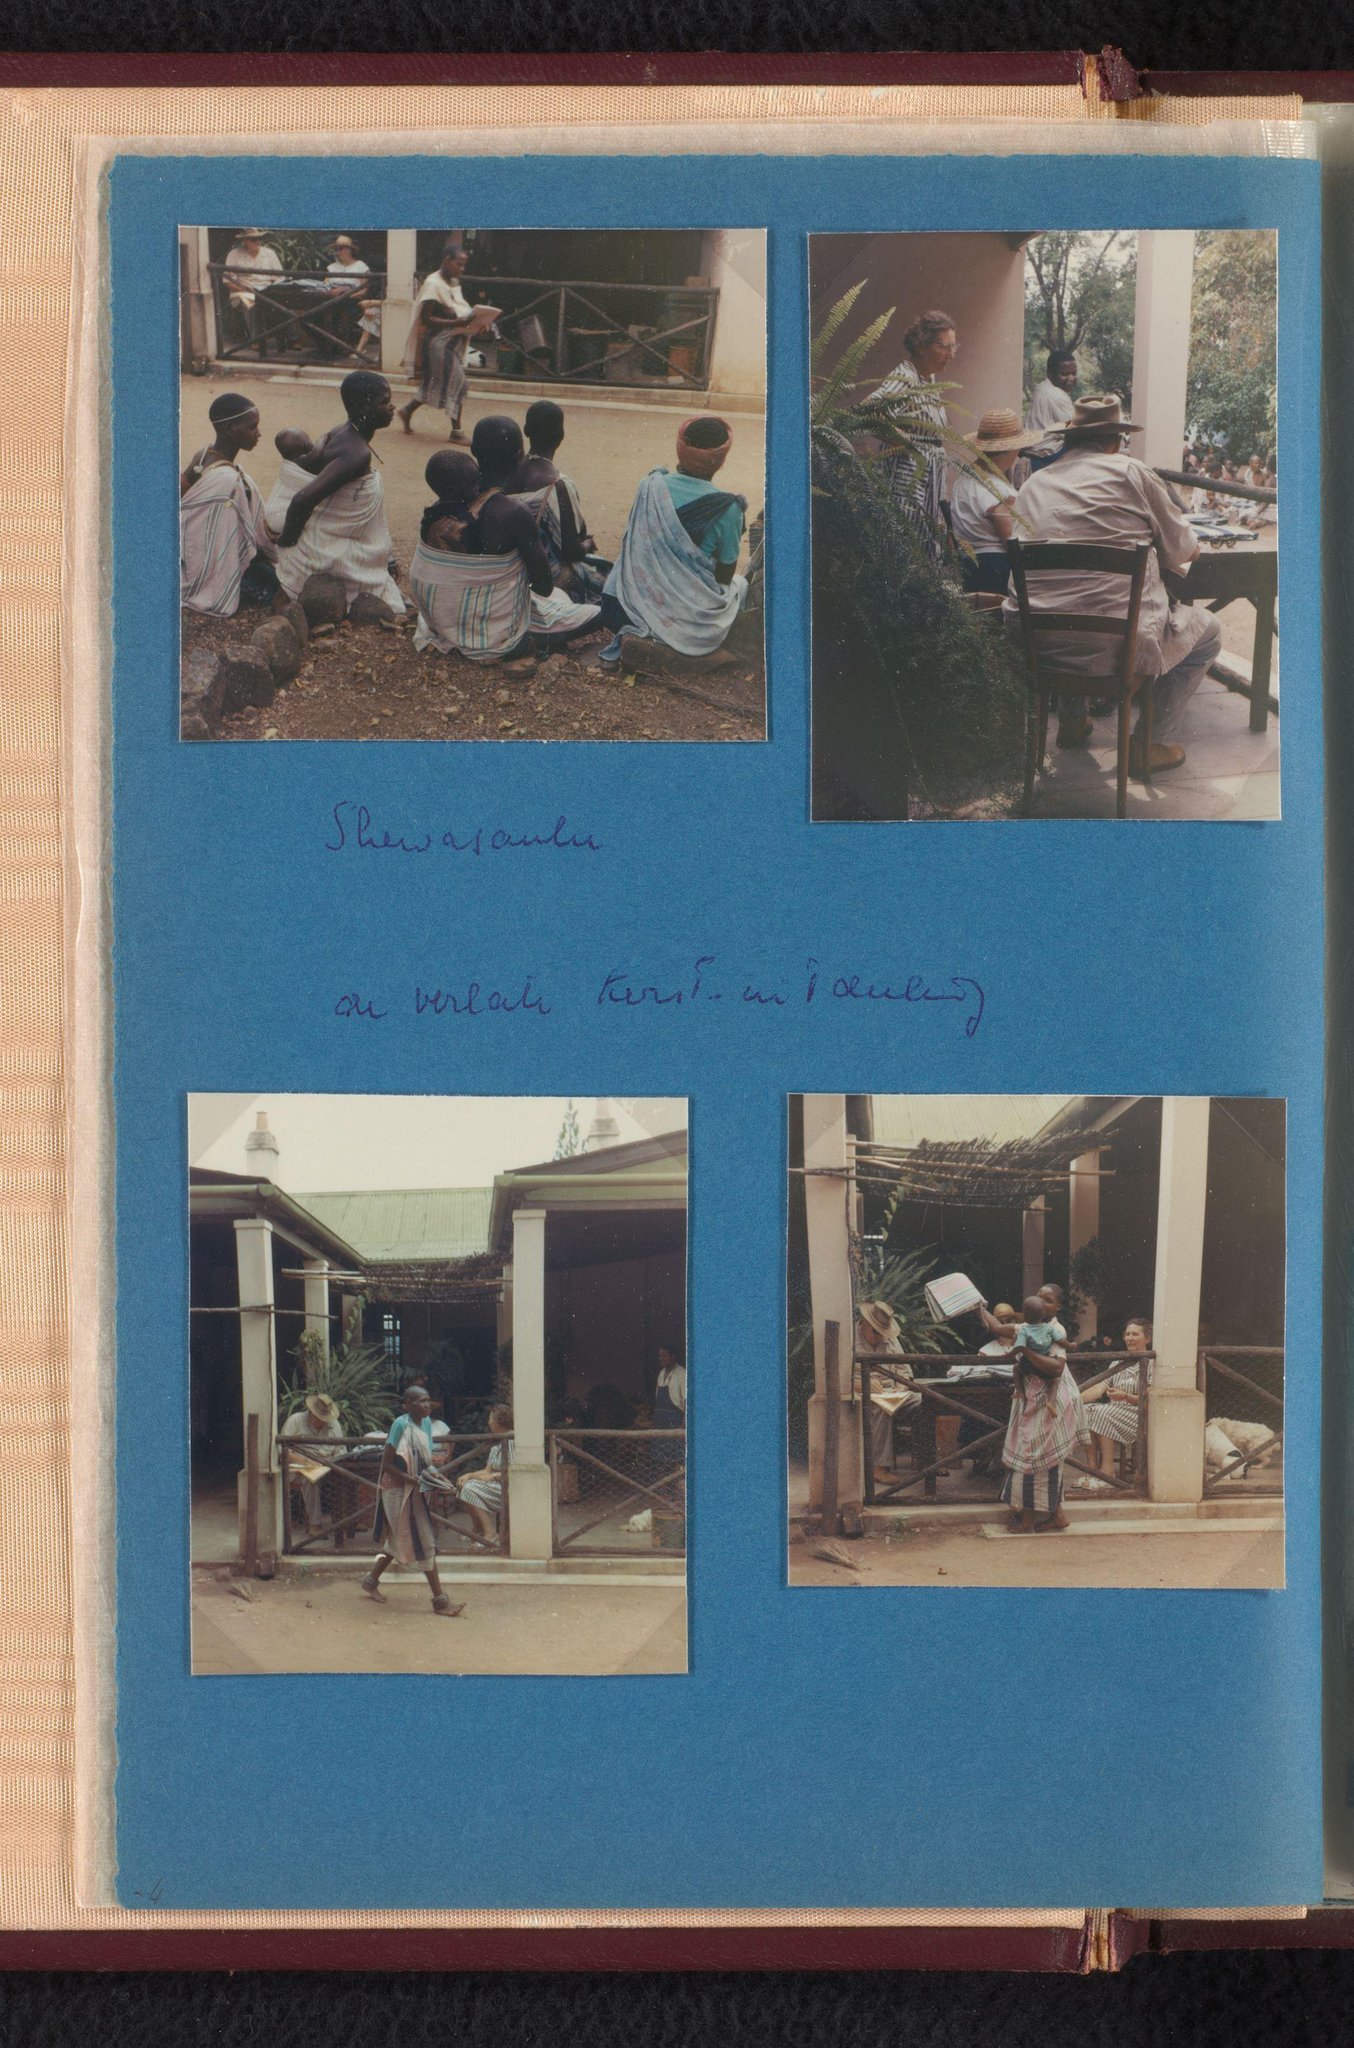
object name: album leaf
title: De verlate kerst-uitdeling [?]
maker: willem jacob van den berg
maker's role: boer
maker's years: 1902-1983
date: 1967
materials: paper, cardboard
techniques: chromogenic print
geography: shewasaulu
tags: willem jacob van den berg, bringing gifts; exchanging gifts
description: Deze foto's zijn onderdeel van een album.